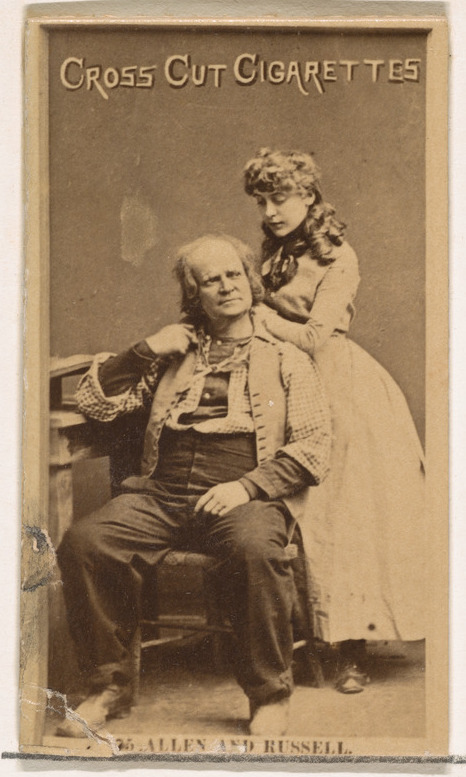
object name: print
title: Card Number 75, Allen and Russell, from the Actors and Actresses series (N145-2) issued by Duke Sons & Co. to promote Cross Cut Cigarettes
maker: w. duke, sons & co.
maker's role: publisher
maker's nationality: american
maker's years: 1870-1920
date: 1880-1889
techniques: albumen silver print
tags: men,portraits,women,actresses